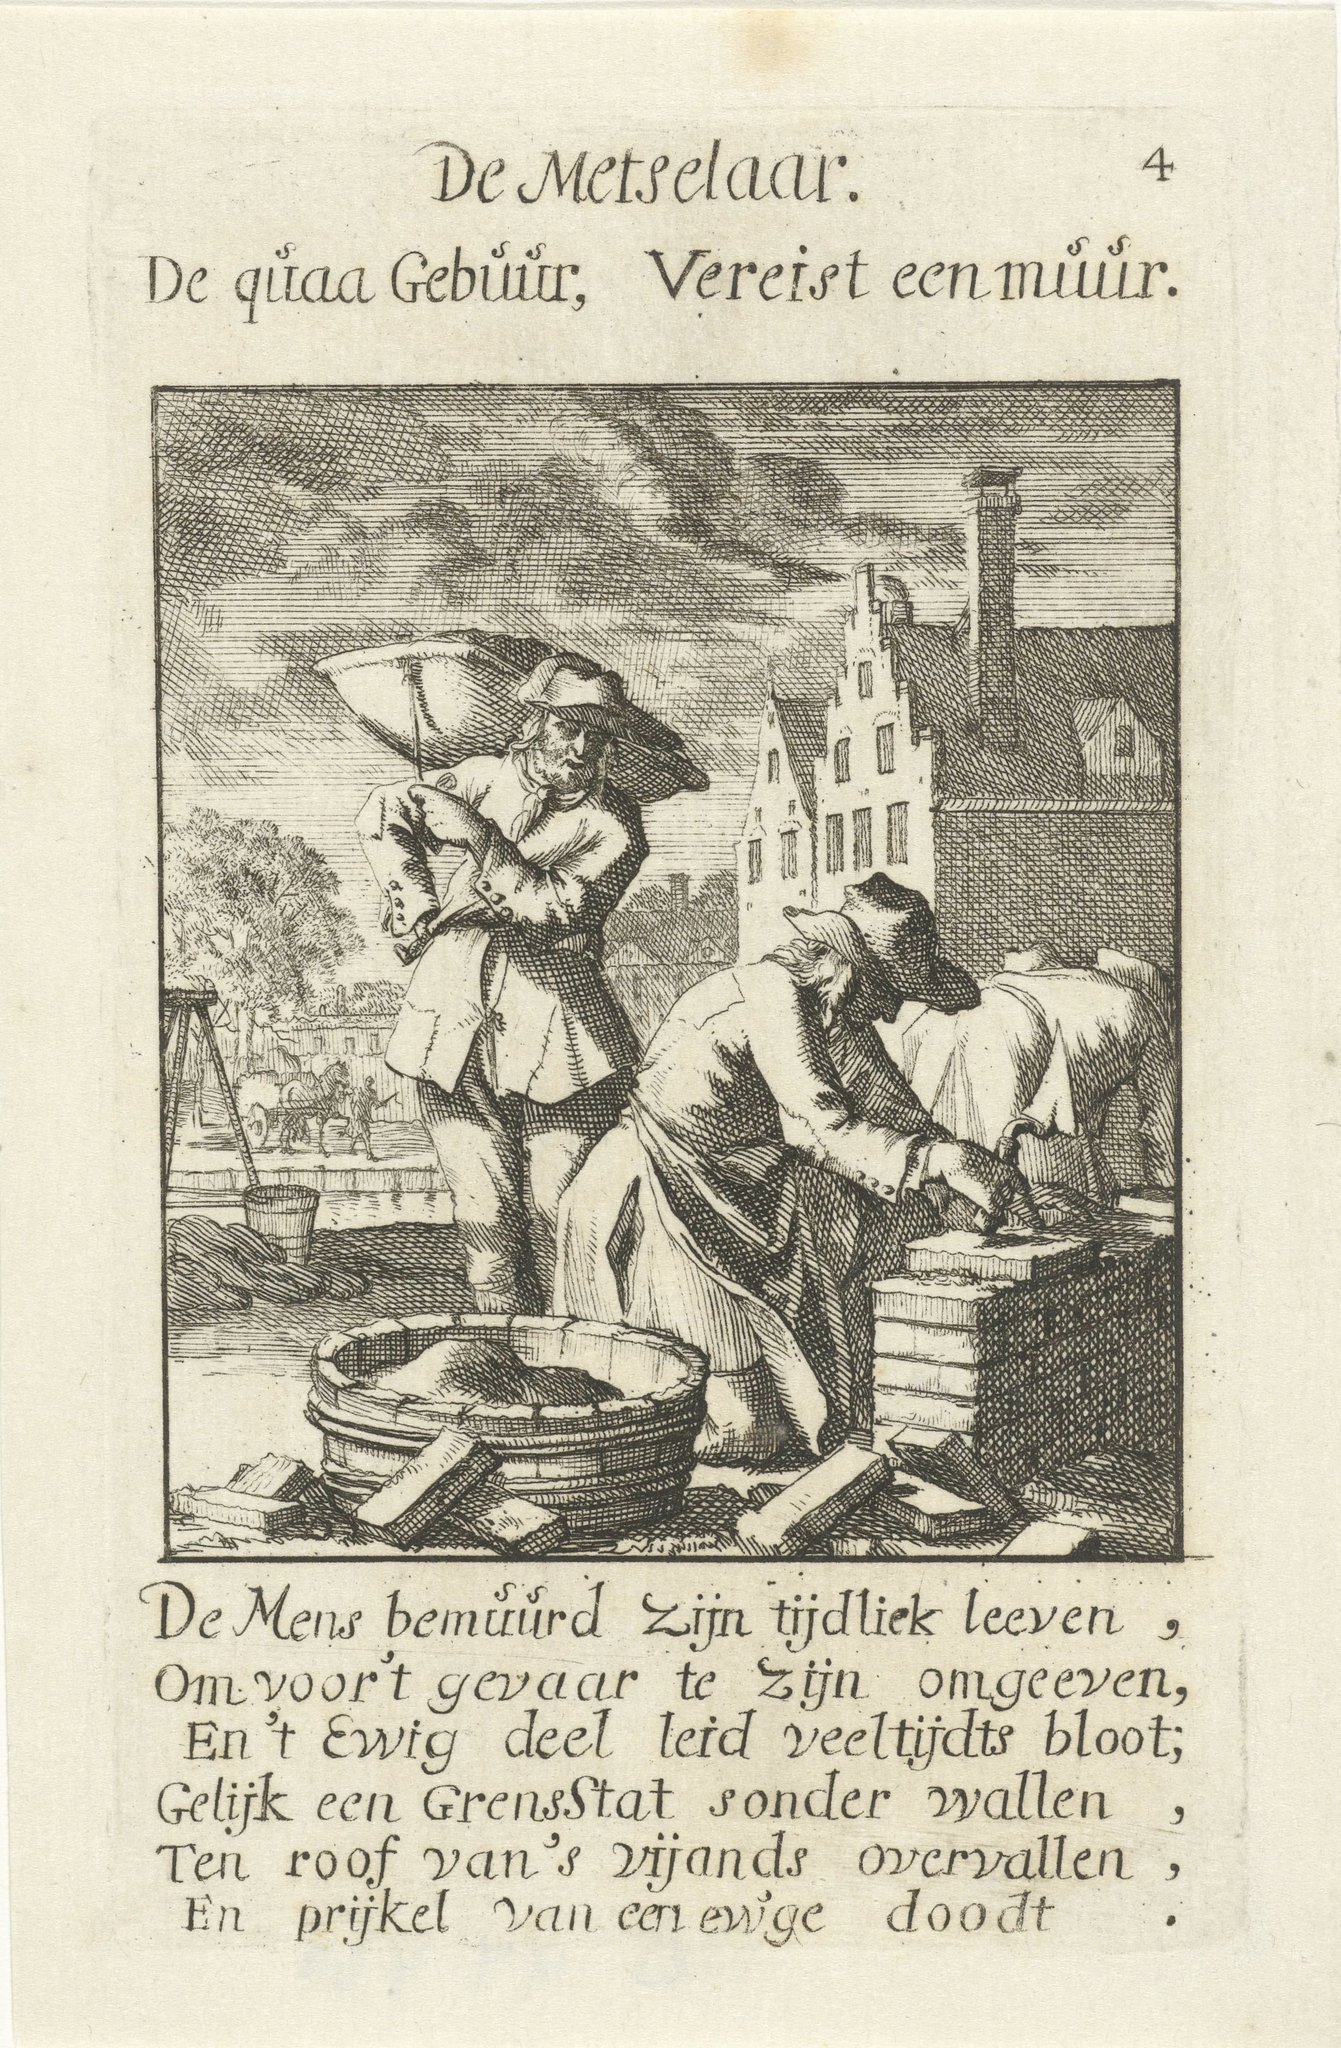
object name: print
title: Metselaar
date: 1694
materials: paper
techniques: etching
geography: amsterdam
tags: handicrafts, craftsman at work, mason at work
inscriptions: collector's mark: Lugt 2228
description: Maakt deel uit van de 100-delige serie beroepsprenten van Jan en Caspar Luyken, getiteld: Het menselyk bedryf. S.l.s.n., 1694 (eerste druk).